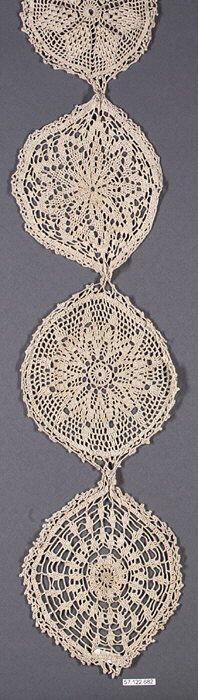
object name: sampler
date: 1801-1900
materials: cotton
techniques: crochet